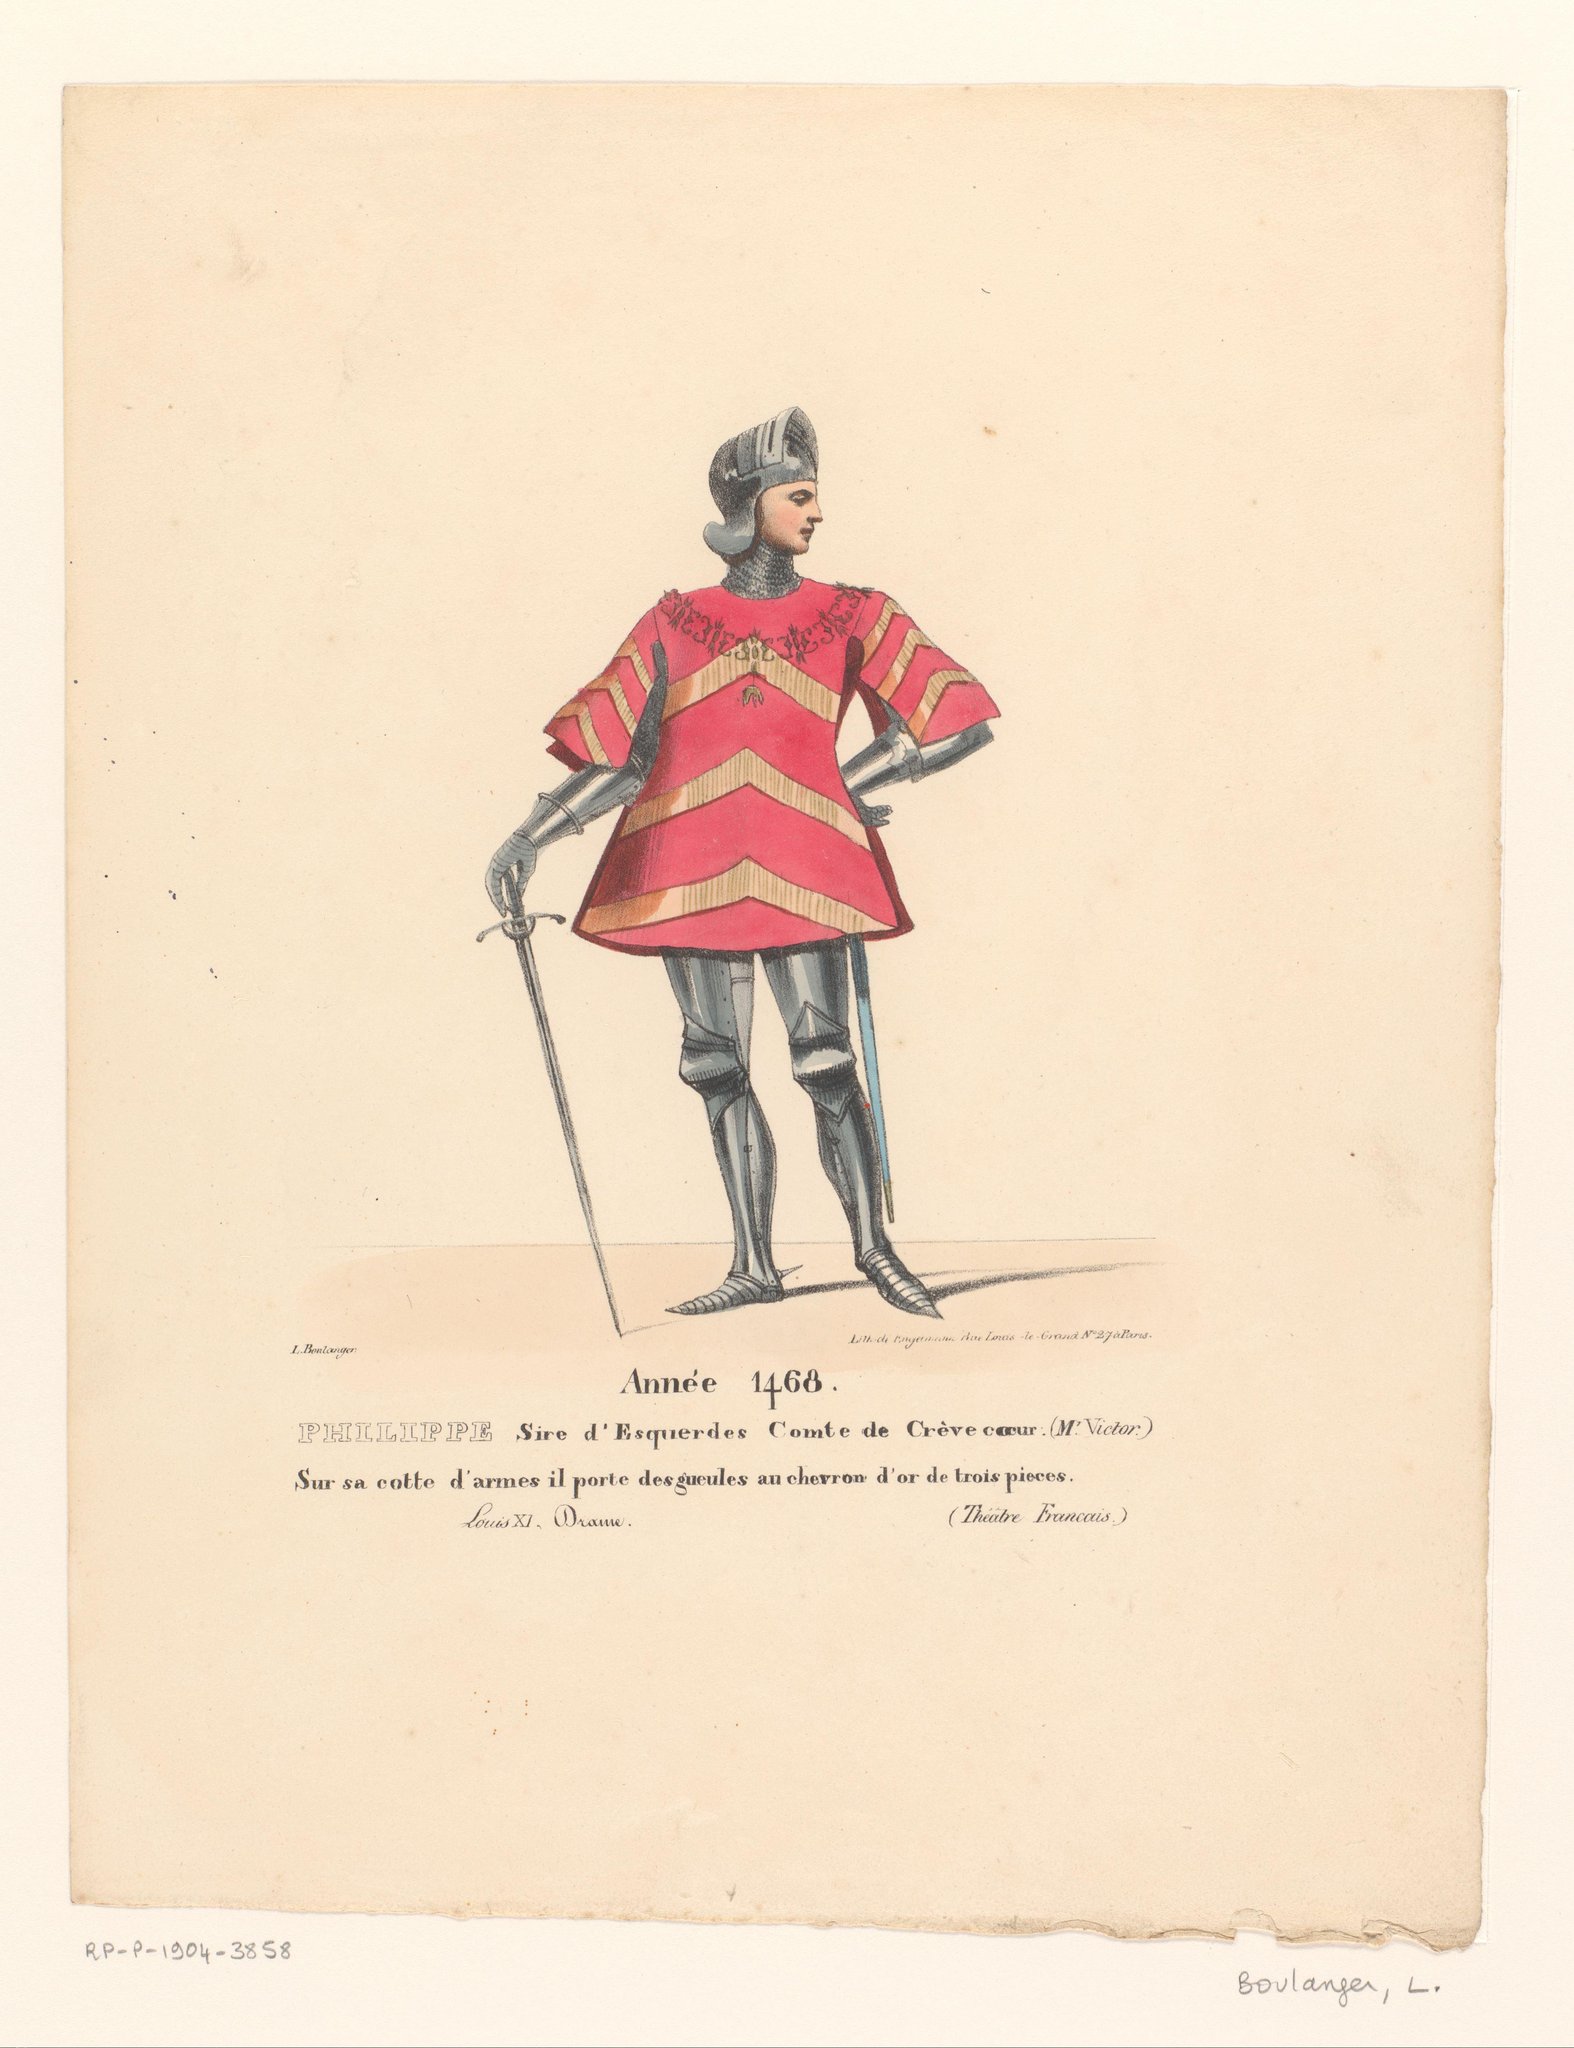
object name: print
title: Théâtre Français: recueil de costumes par MM. J. Alaux et L. Duponchel d'après les dessins manuscrits de la Bibliothèque de la Comédie-Française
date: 1826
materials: paper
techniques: hand coloring, lithograph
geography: paris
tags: stage costume, historical persons, actor (on the stage), tragedy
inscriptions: collector's mark: Lugt 2228a